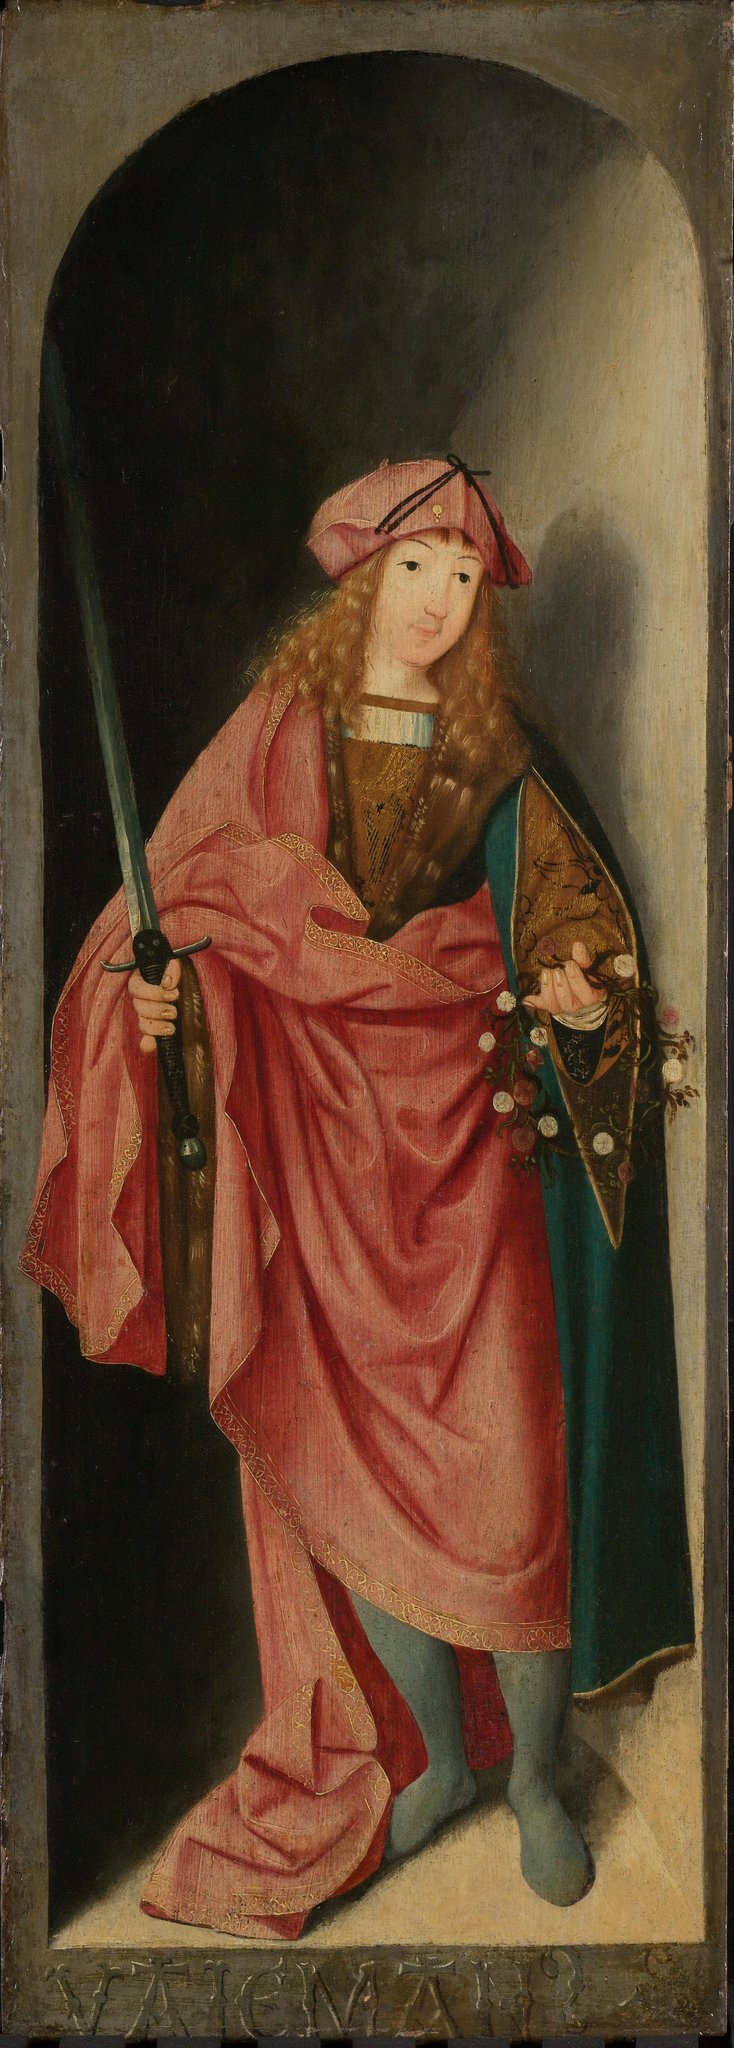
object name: zijpaneel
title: Saint Valerian, left wing of a triptych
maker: master of the brunswick diptych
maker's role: painter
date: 1490-1500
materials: oil, panel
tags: male saints (with name)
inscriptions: inscription, bottom, on the niche: ‘VALEM [= RI ?] AN [...S]’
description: De buitenzijde van luik van een drieluik. De heilige Valerianus, staande in een stenen nis, ten voeten uit, het zwaard in de rechterhand en een bloemenkrans in de linkerhand. Pendant van SK-A-3306.